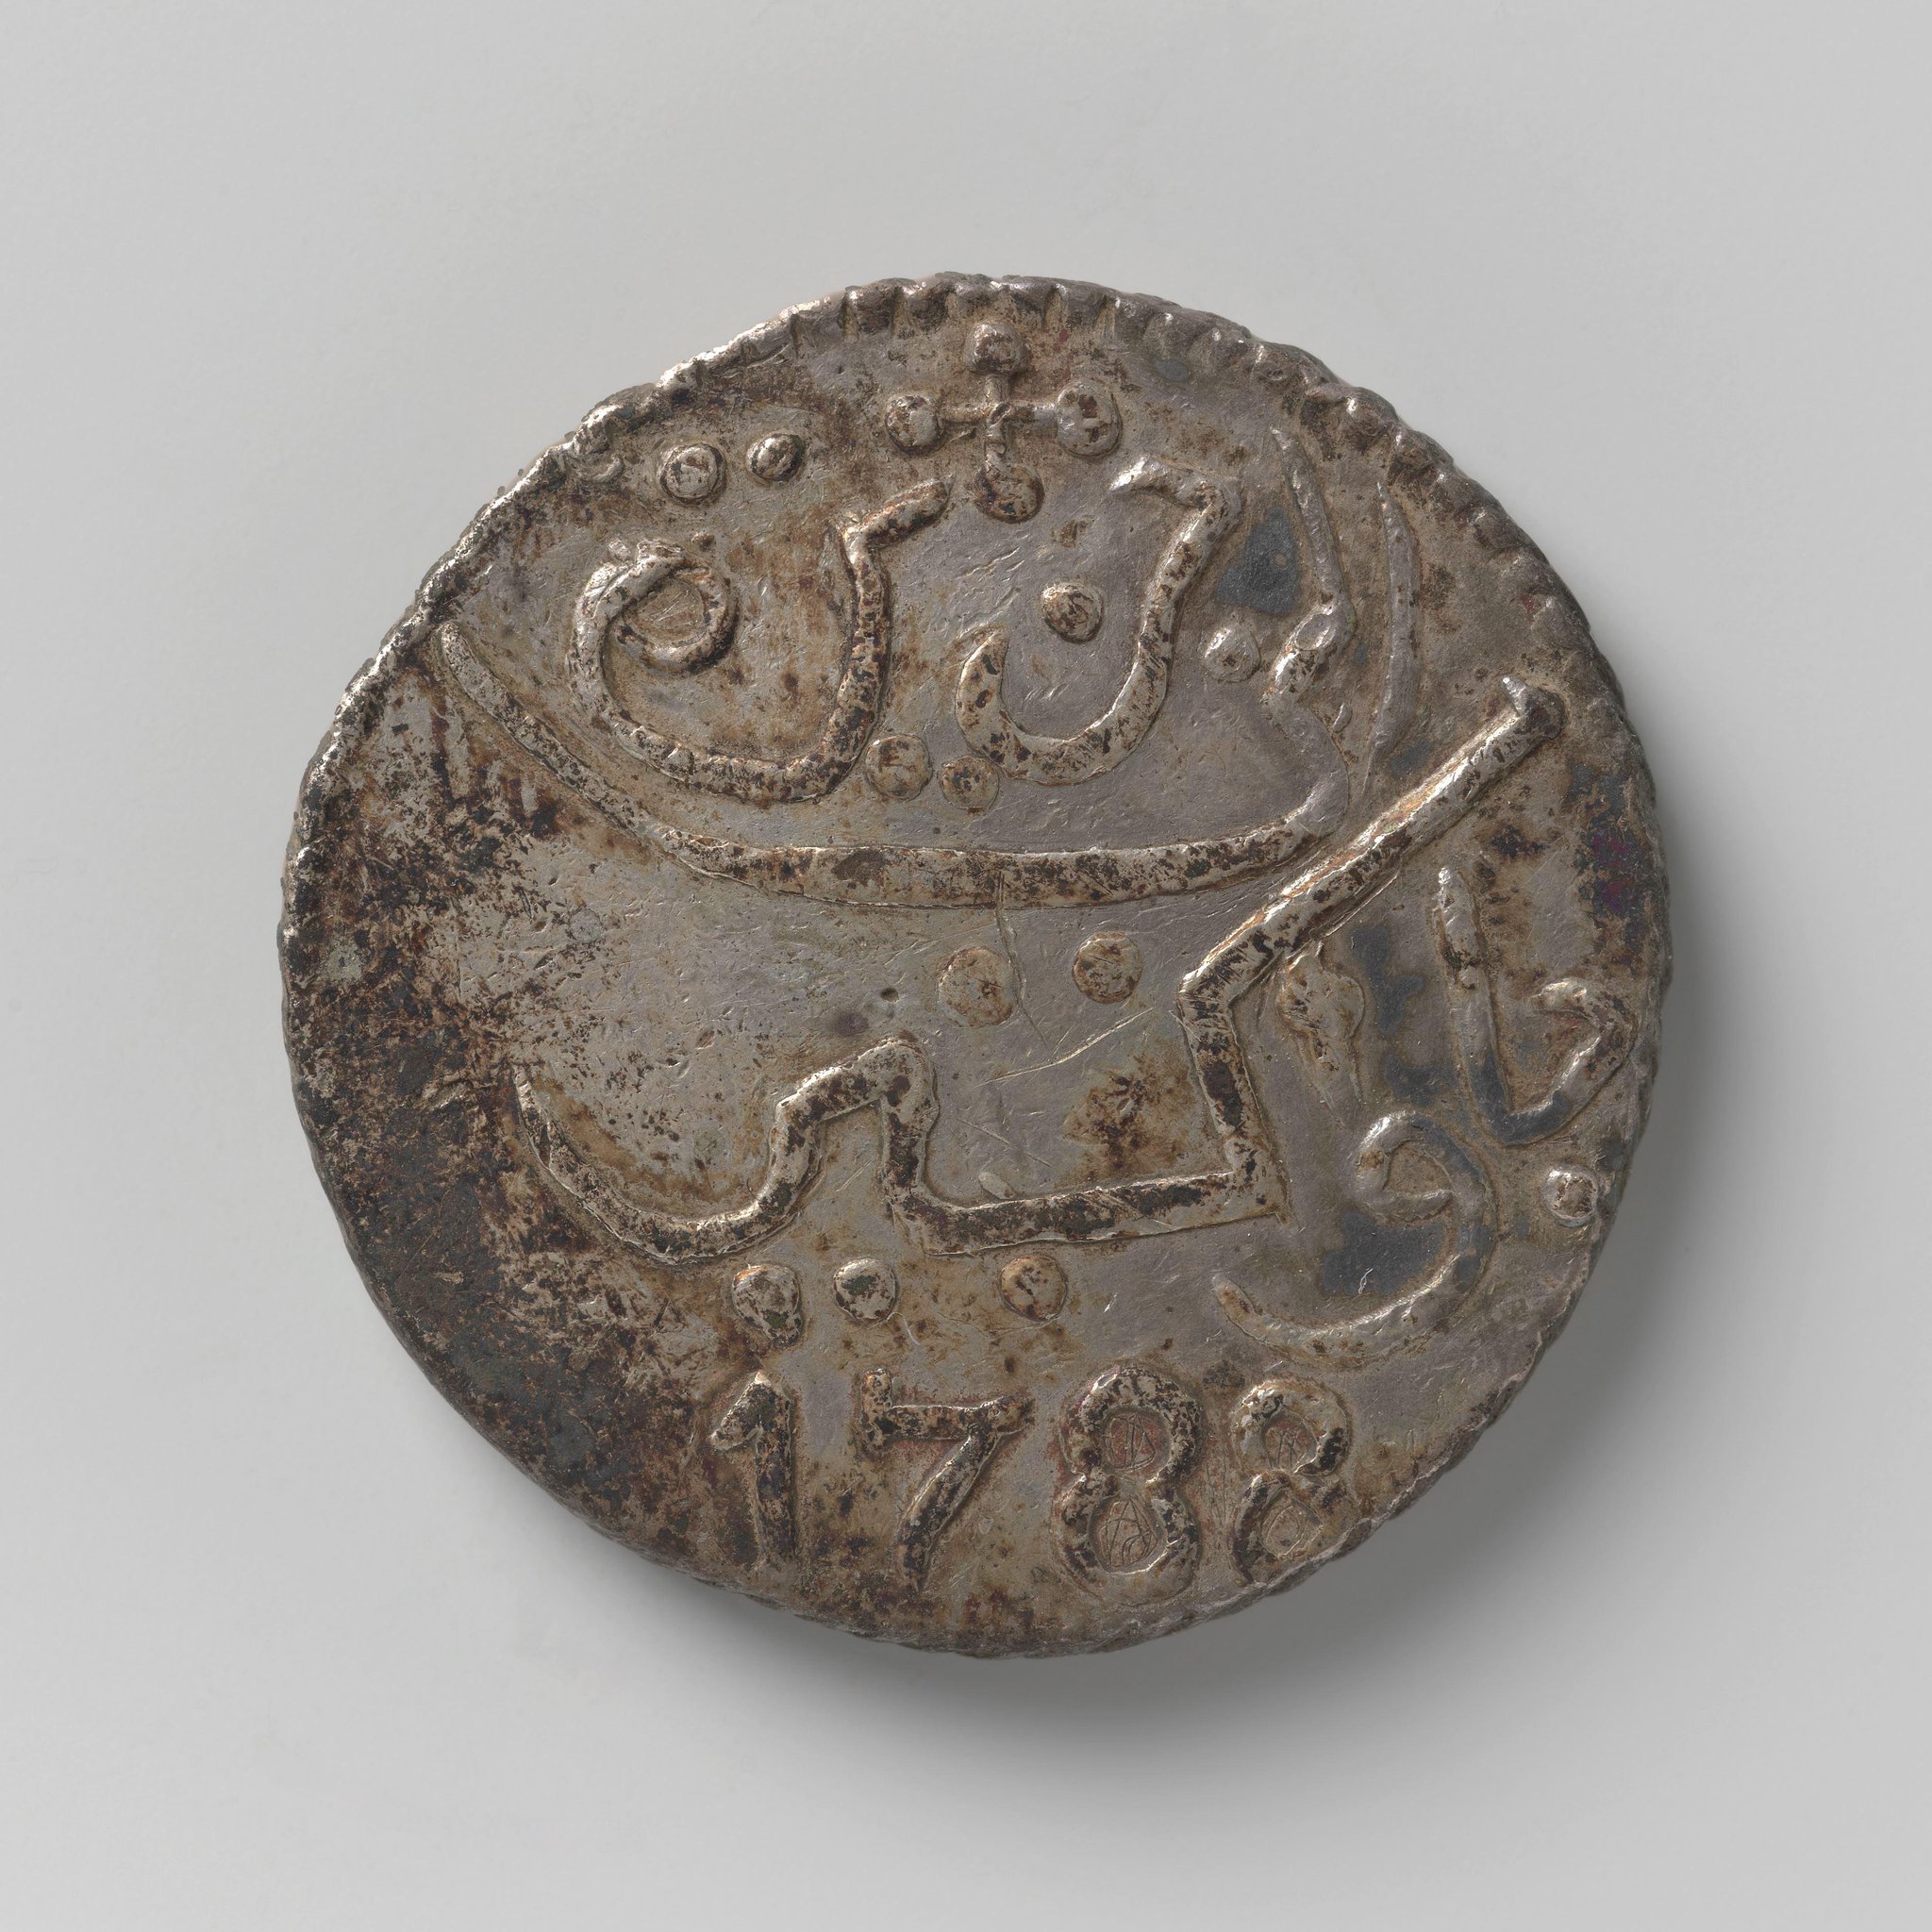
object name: coin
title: Zilveren ropij van de VOC uit Java, 1788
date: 1788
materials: silver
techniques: striking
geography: batavia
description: Zilveren munt. Voorzijde: tweeregelig opschrift in Arabische letters. Daarboven muntteken en daaronder jaartal. Keerzijde: drieregelig opschrift in Arabische letters. Kabelrand.